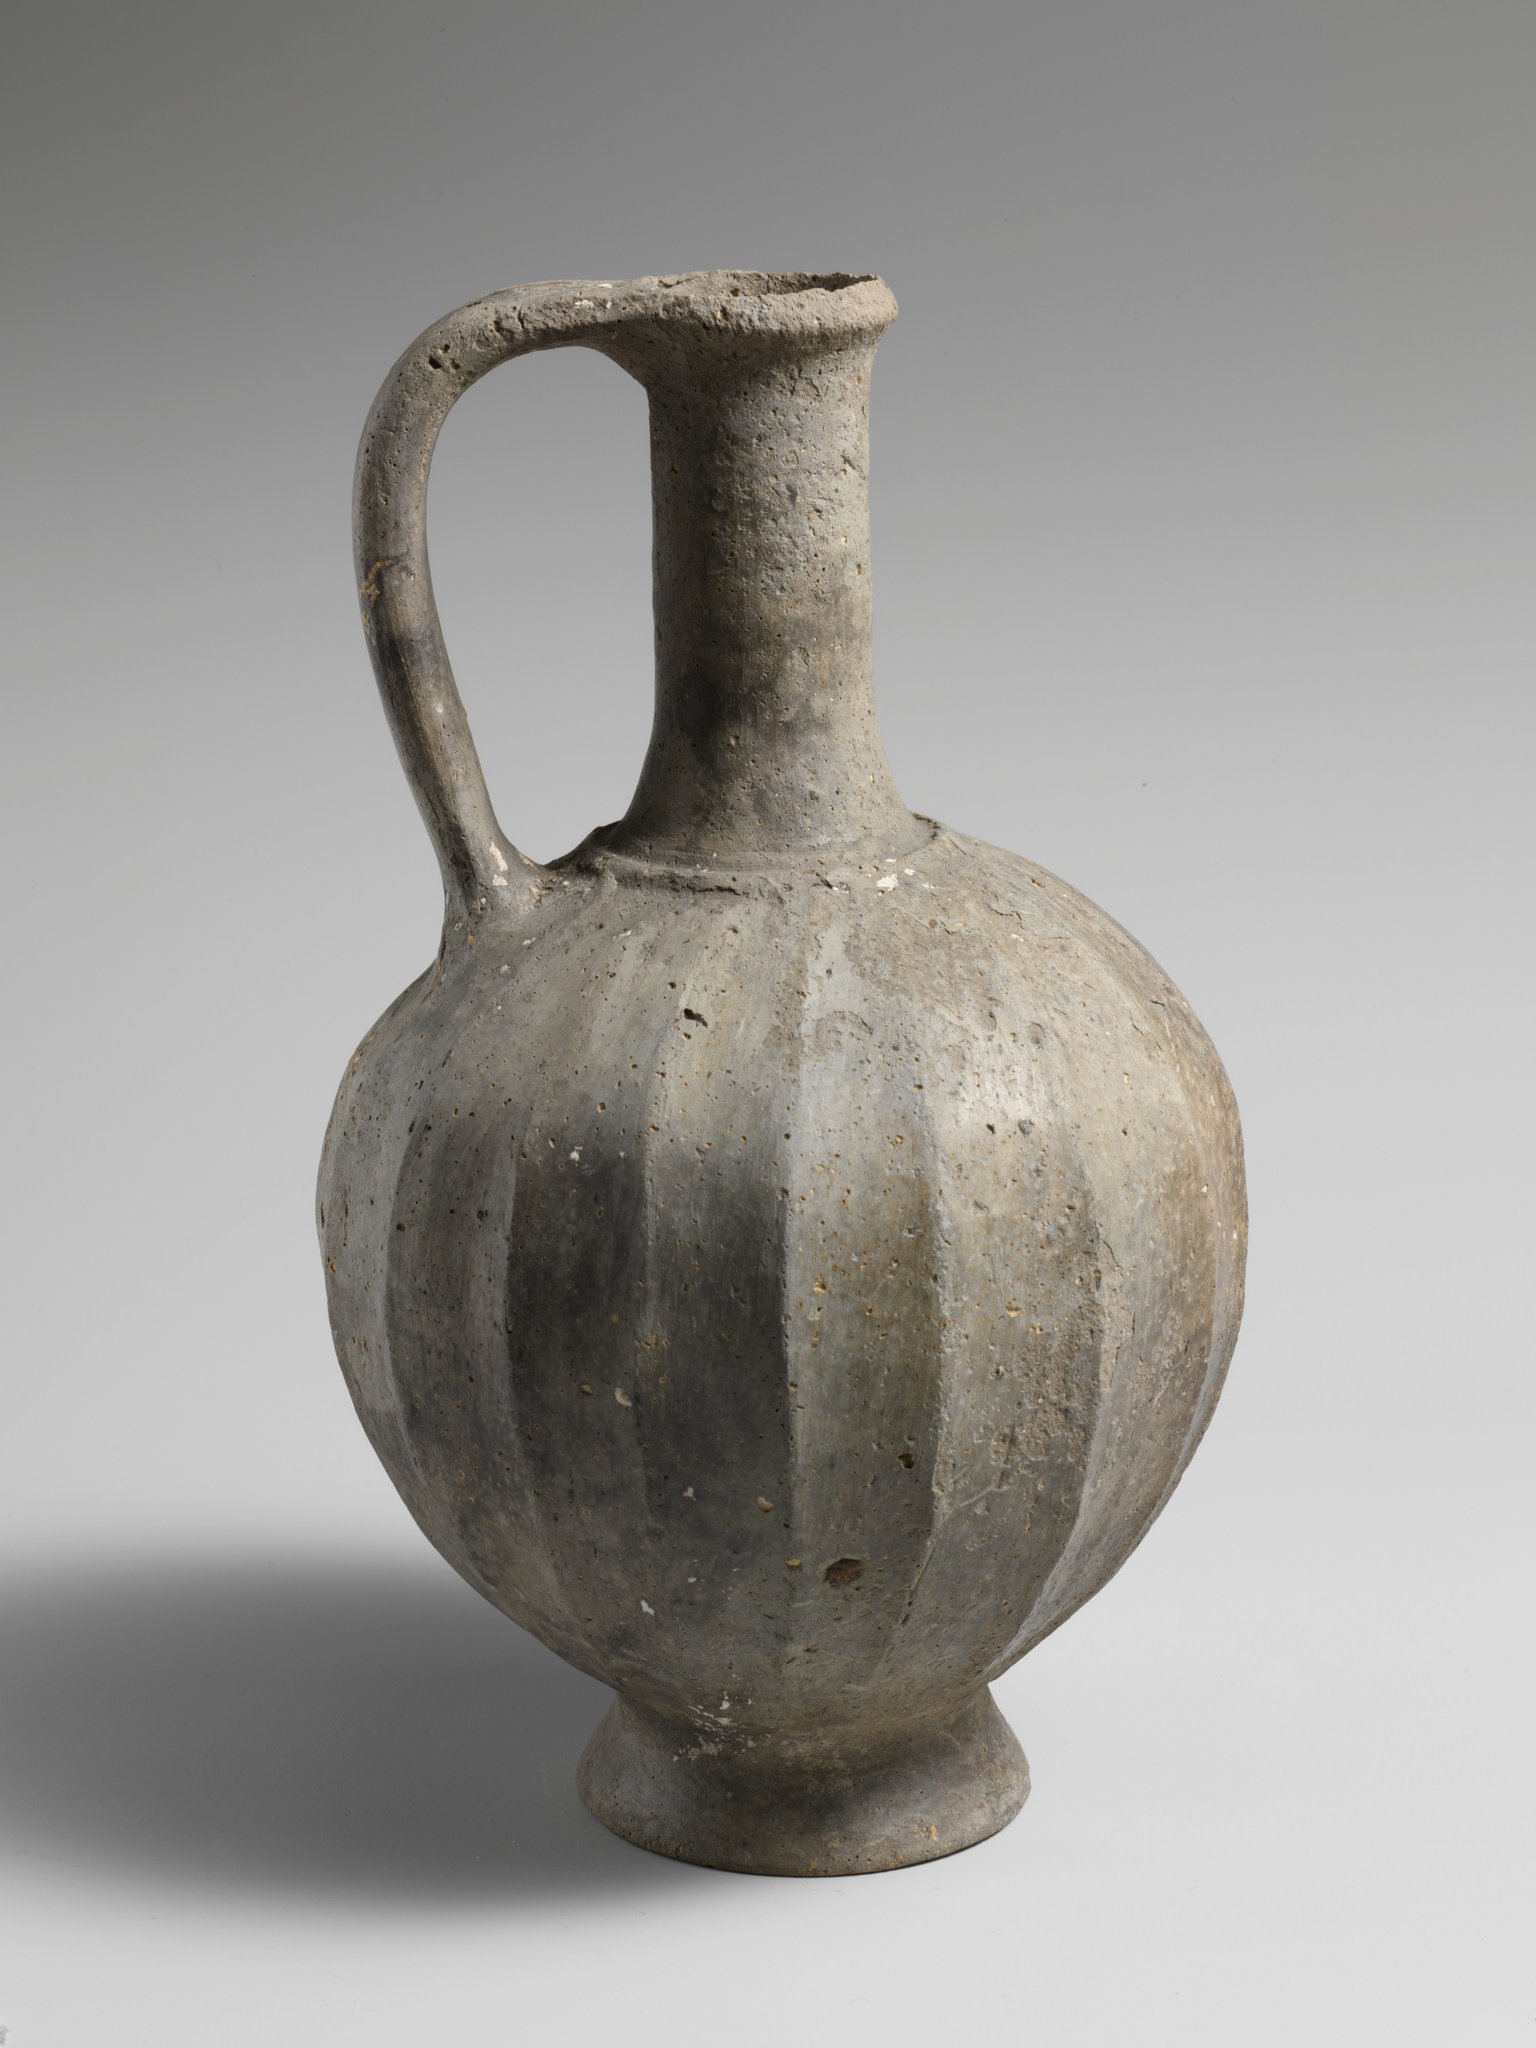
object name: jug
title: Terracotta jug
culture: cypriot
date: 1600-1050 BCE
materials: terracotta